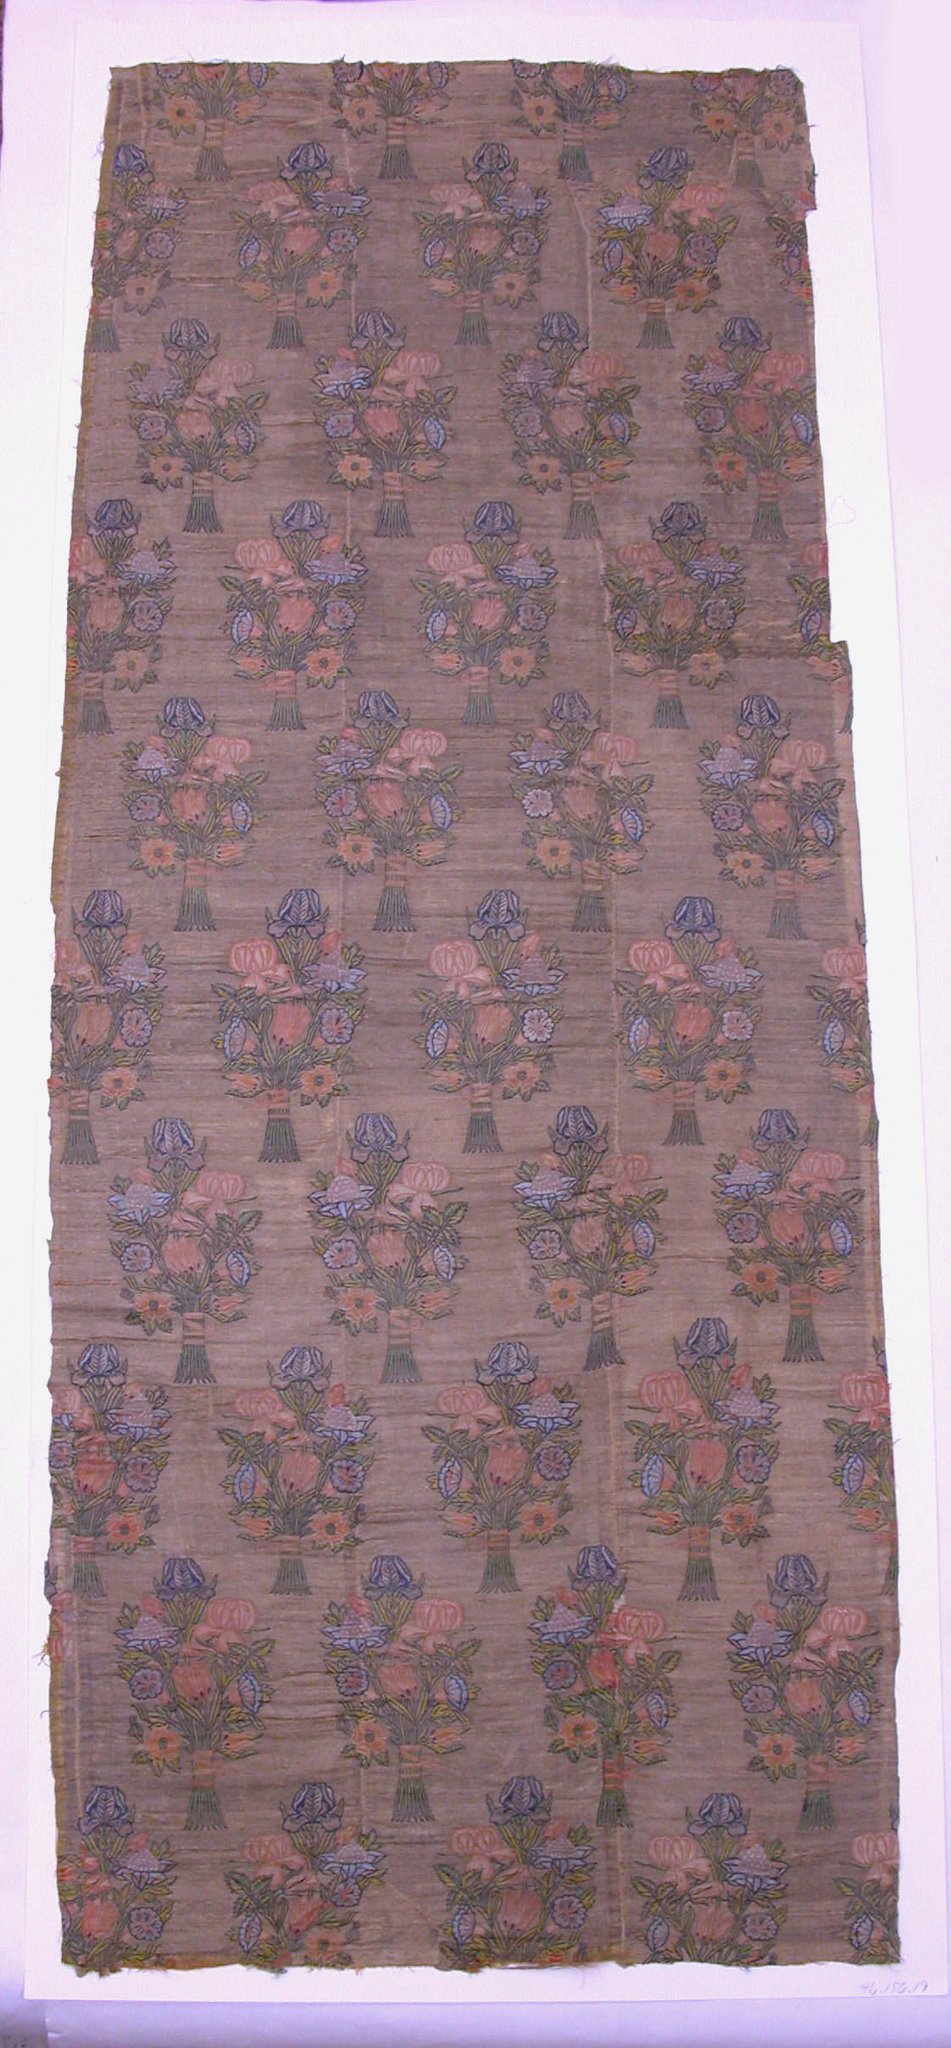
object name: fragment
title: Floral Textile Fragment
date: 1601-1633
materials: metal thread, silk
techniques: lampas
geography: iran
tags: flowers